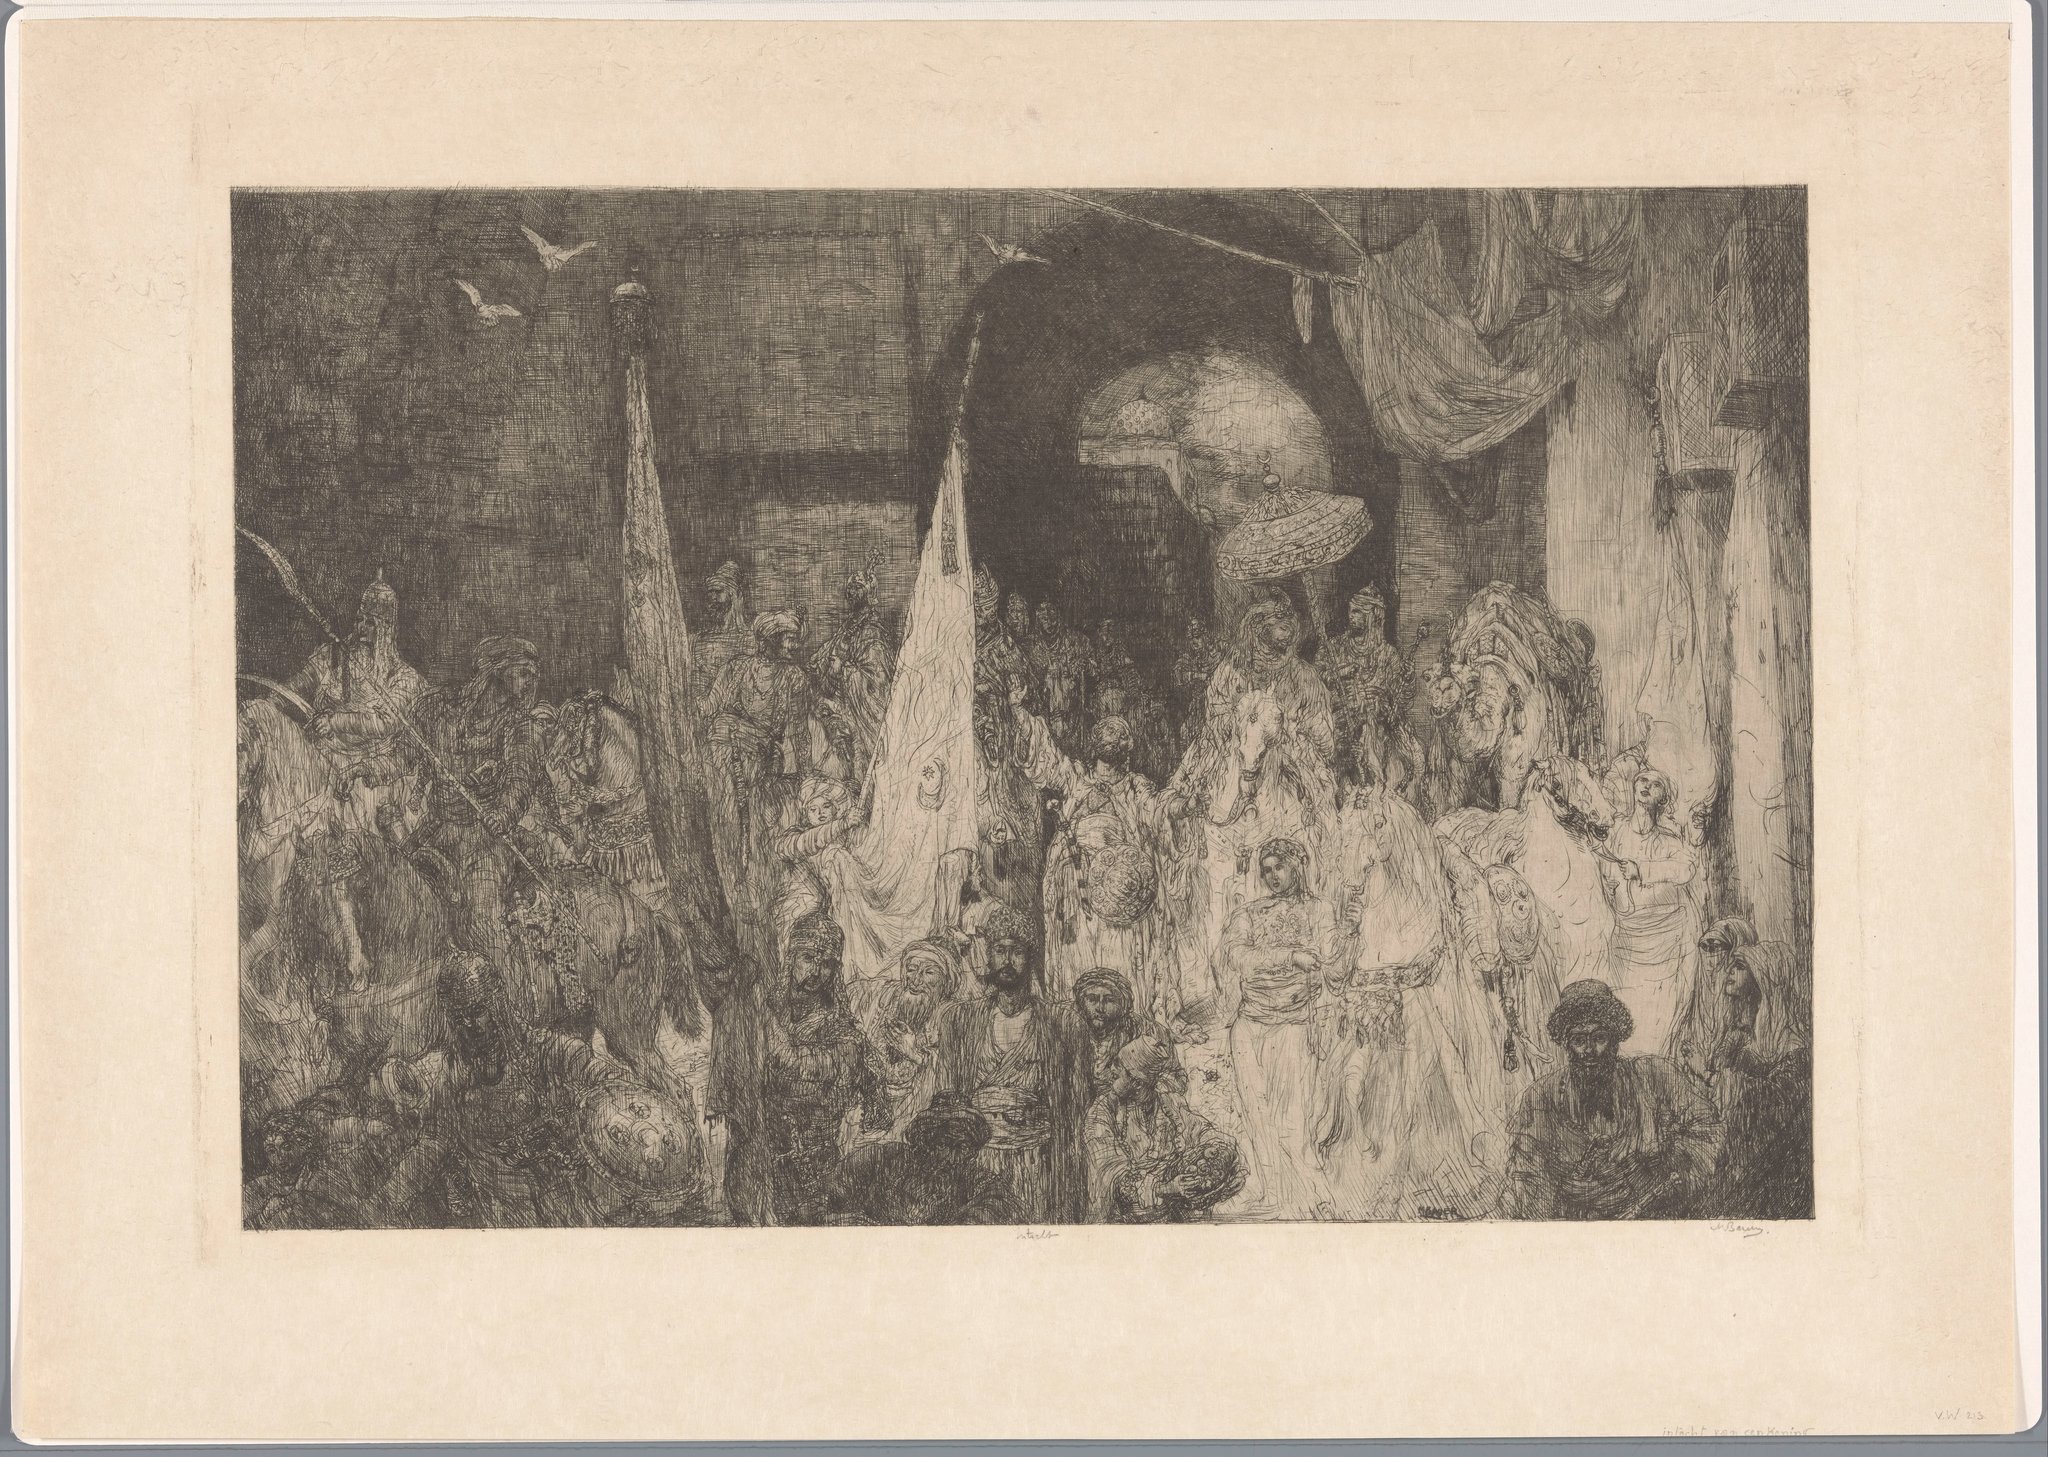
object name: print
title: Intocht van een koning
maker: marius bauer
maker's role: draughtsman, print maker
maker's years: 1867-1932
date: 1894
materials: paper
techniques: etching, intaglio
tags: riding a horse, ass, or mule; rider, horseman, hoofed animals: camel, king, parasol, sunshade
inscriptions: collector's mark: Lugt 2228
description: Een dienaar houdt een man op een paard een parasol boven het hoofd. Om hen heen een menigte mensen, waaronder ruiters te paard en mannen in harnas. Rechts op de achtergrond een kameel. Linksboven twee vliegende duiven.